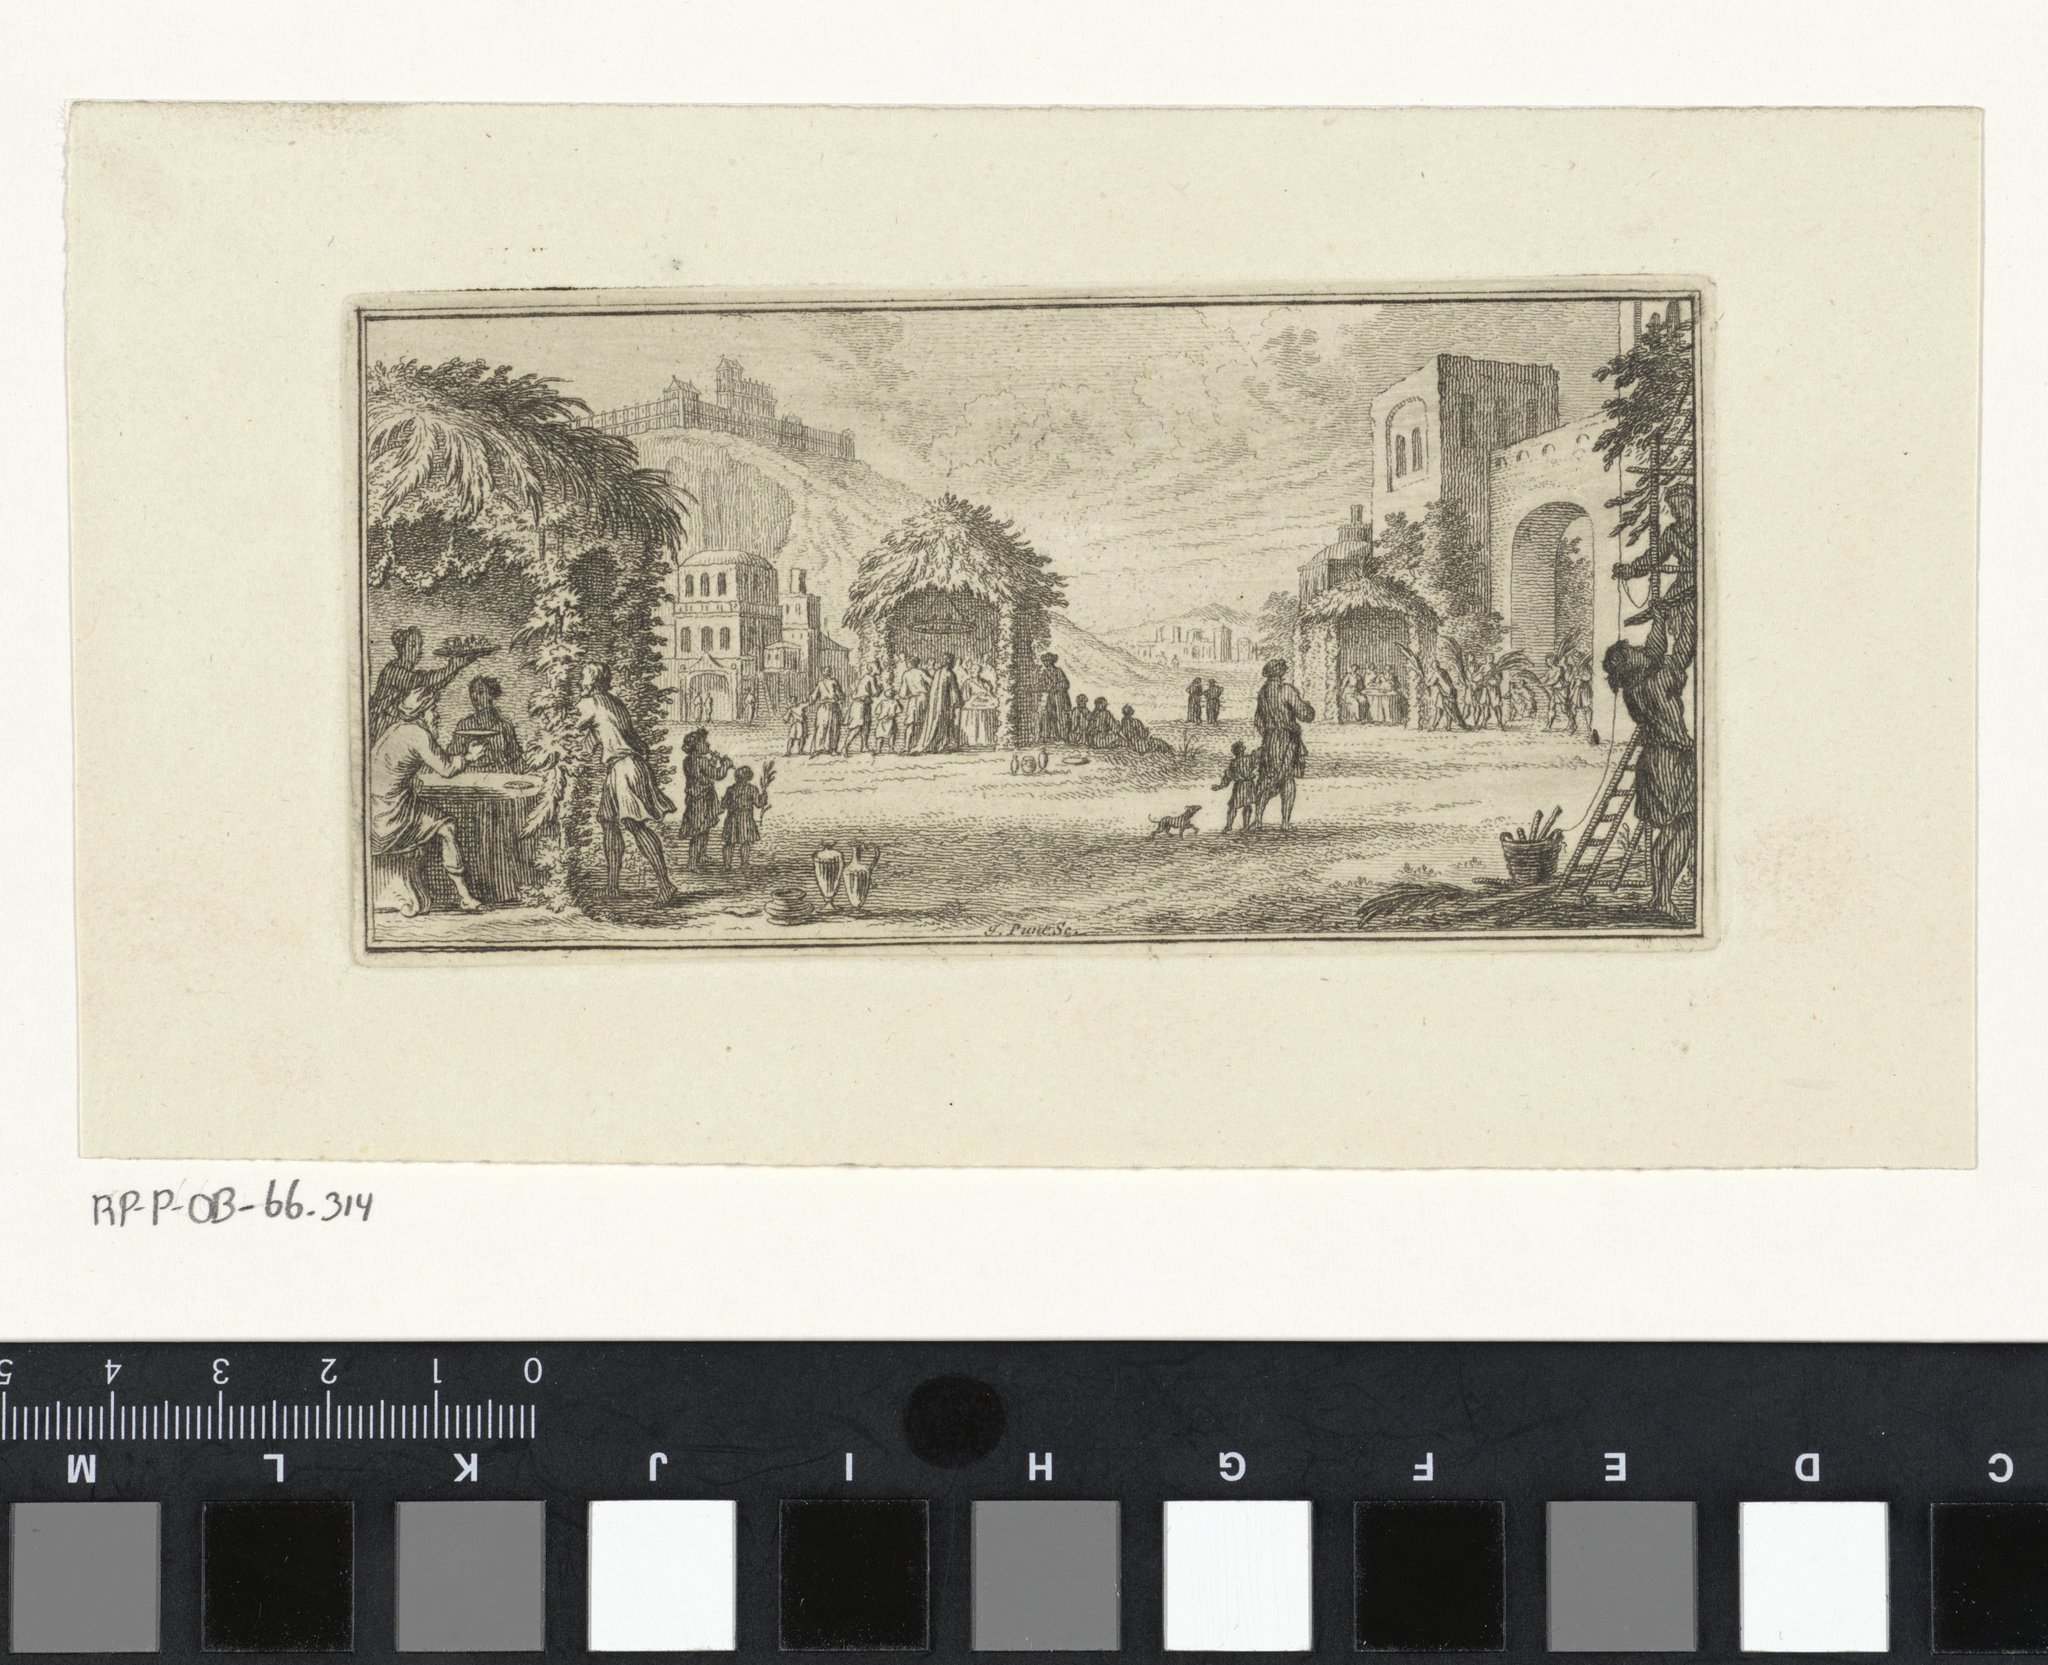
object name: print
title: Loofhuttenfeest (Soekot)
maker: jan punt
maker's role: draughtsman, print maker, publisher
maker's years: 1711-1779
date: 1726-1779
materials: paper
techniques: engraving, etching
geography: amsterdam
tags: 'sukkot', feast of the tabernacles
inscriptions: collector's mark: Lugt 2228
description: Op een veld voor de stadspoort zijn loofhutten gebouwd om het feest te vieren. In de hutten zit men aan de maaltijd.